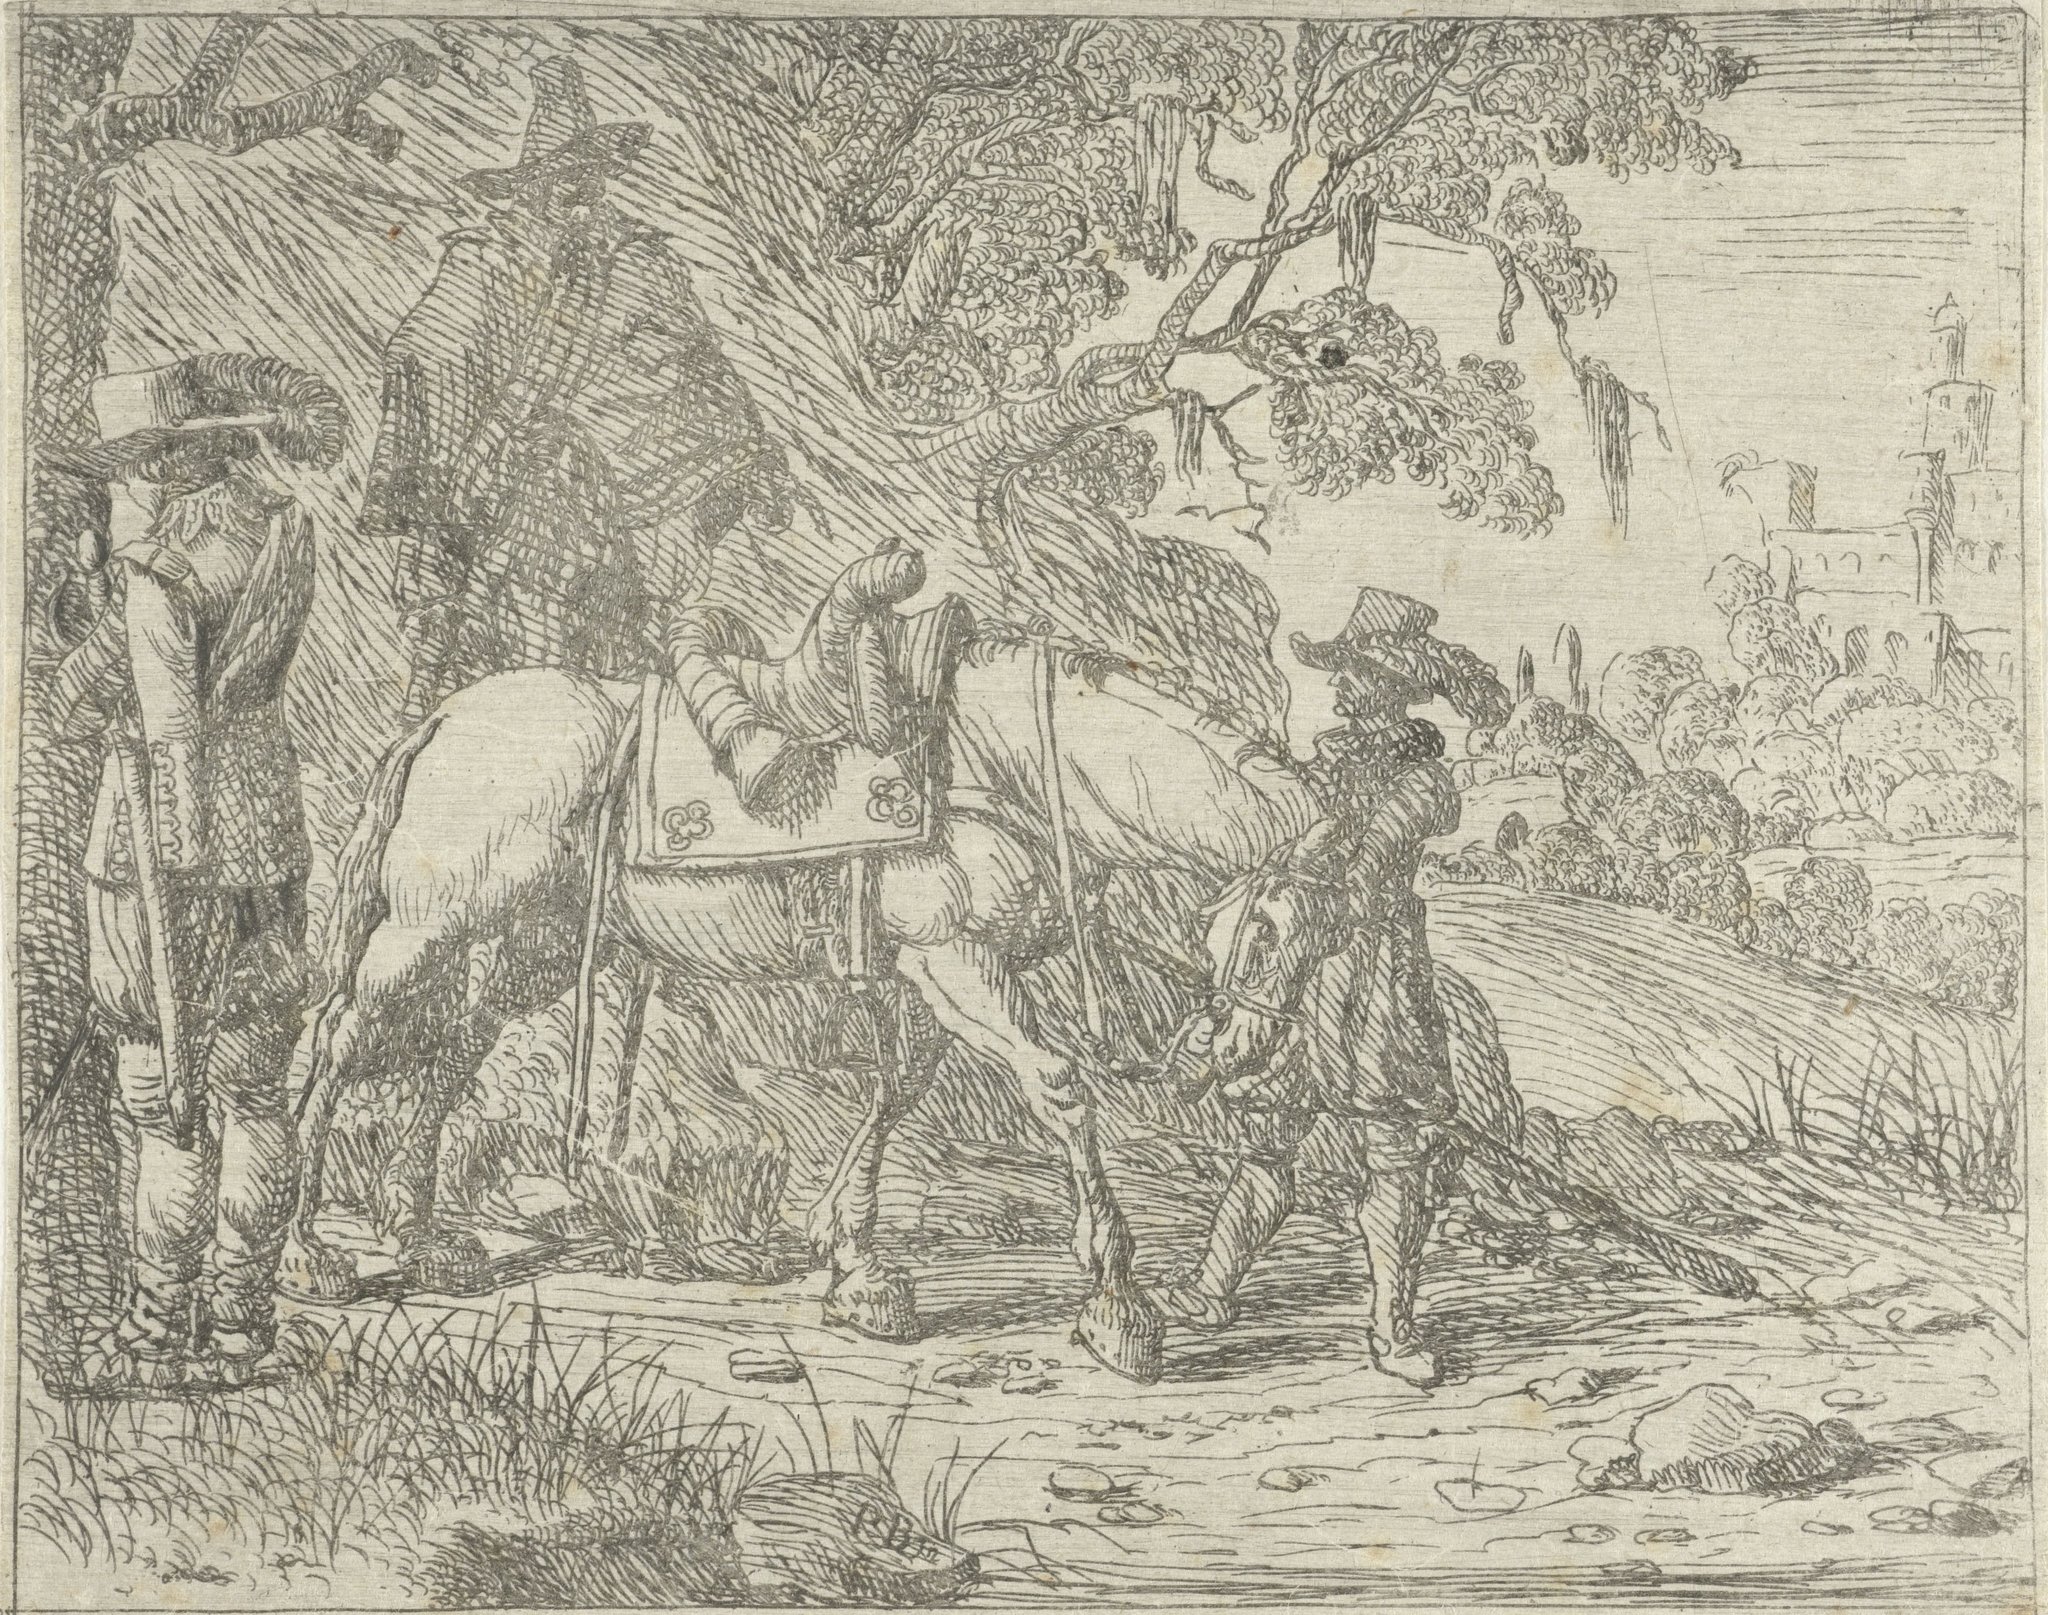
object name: print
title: Gezadeld paard met soldaten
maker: pieter bodding van laer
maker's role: draughtsman, painter, print maker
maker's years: 1599-1642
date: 1609-1642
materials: paper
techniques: etching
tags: riding a horse, ass, or mule; rider, horseman, private soldier, horse, urination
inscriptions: collector's mark: Lugt 2228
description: Gezicht op een landschap met gezadeld paard, twee soldaten en een derde figuur met hoed op de achtergrond. Links plast een soldaat tegen een boom terwijl de tweede soldaat het paard bij de teugels vasthoudt.